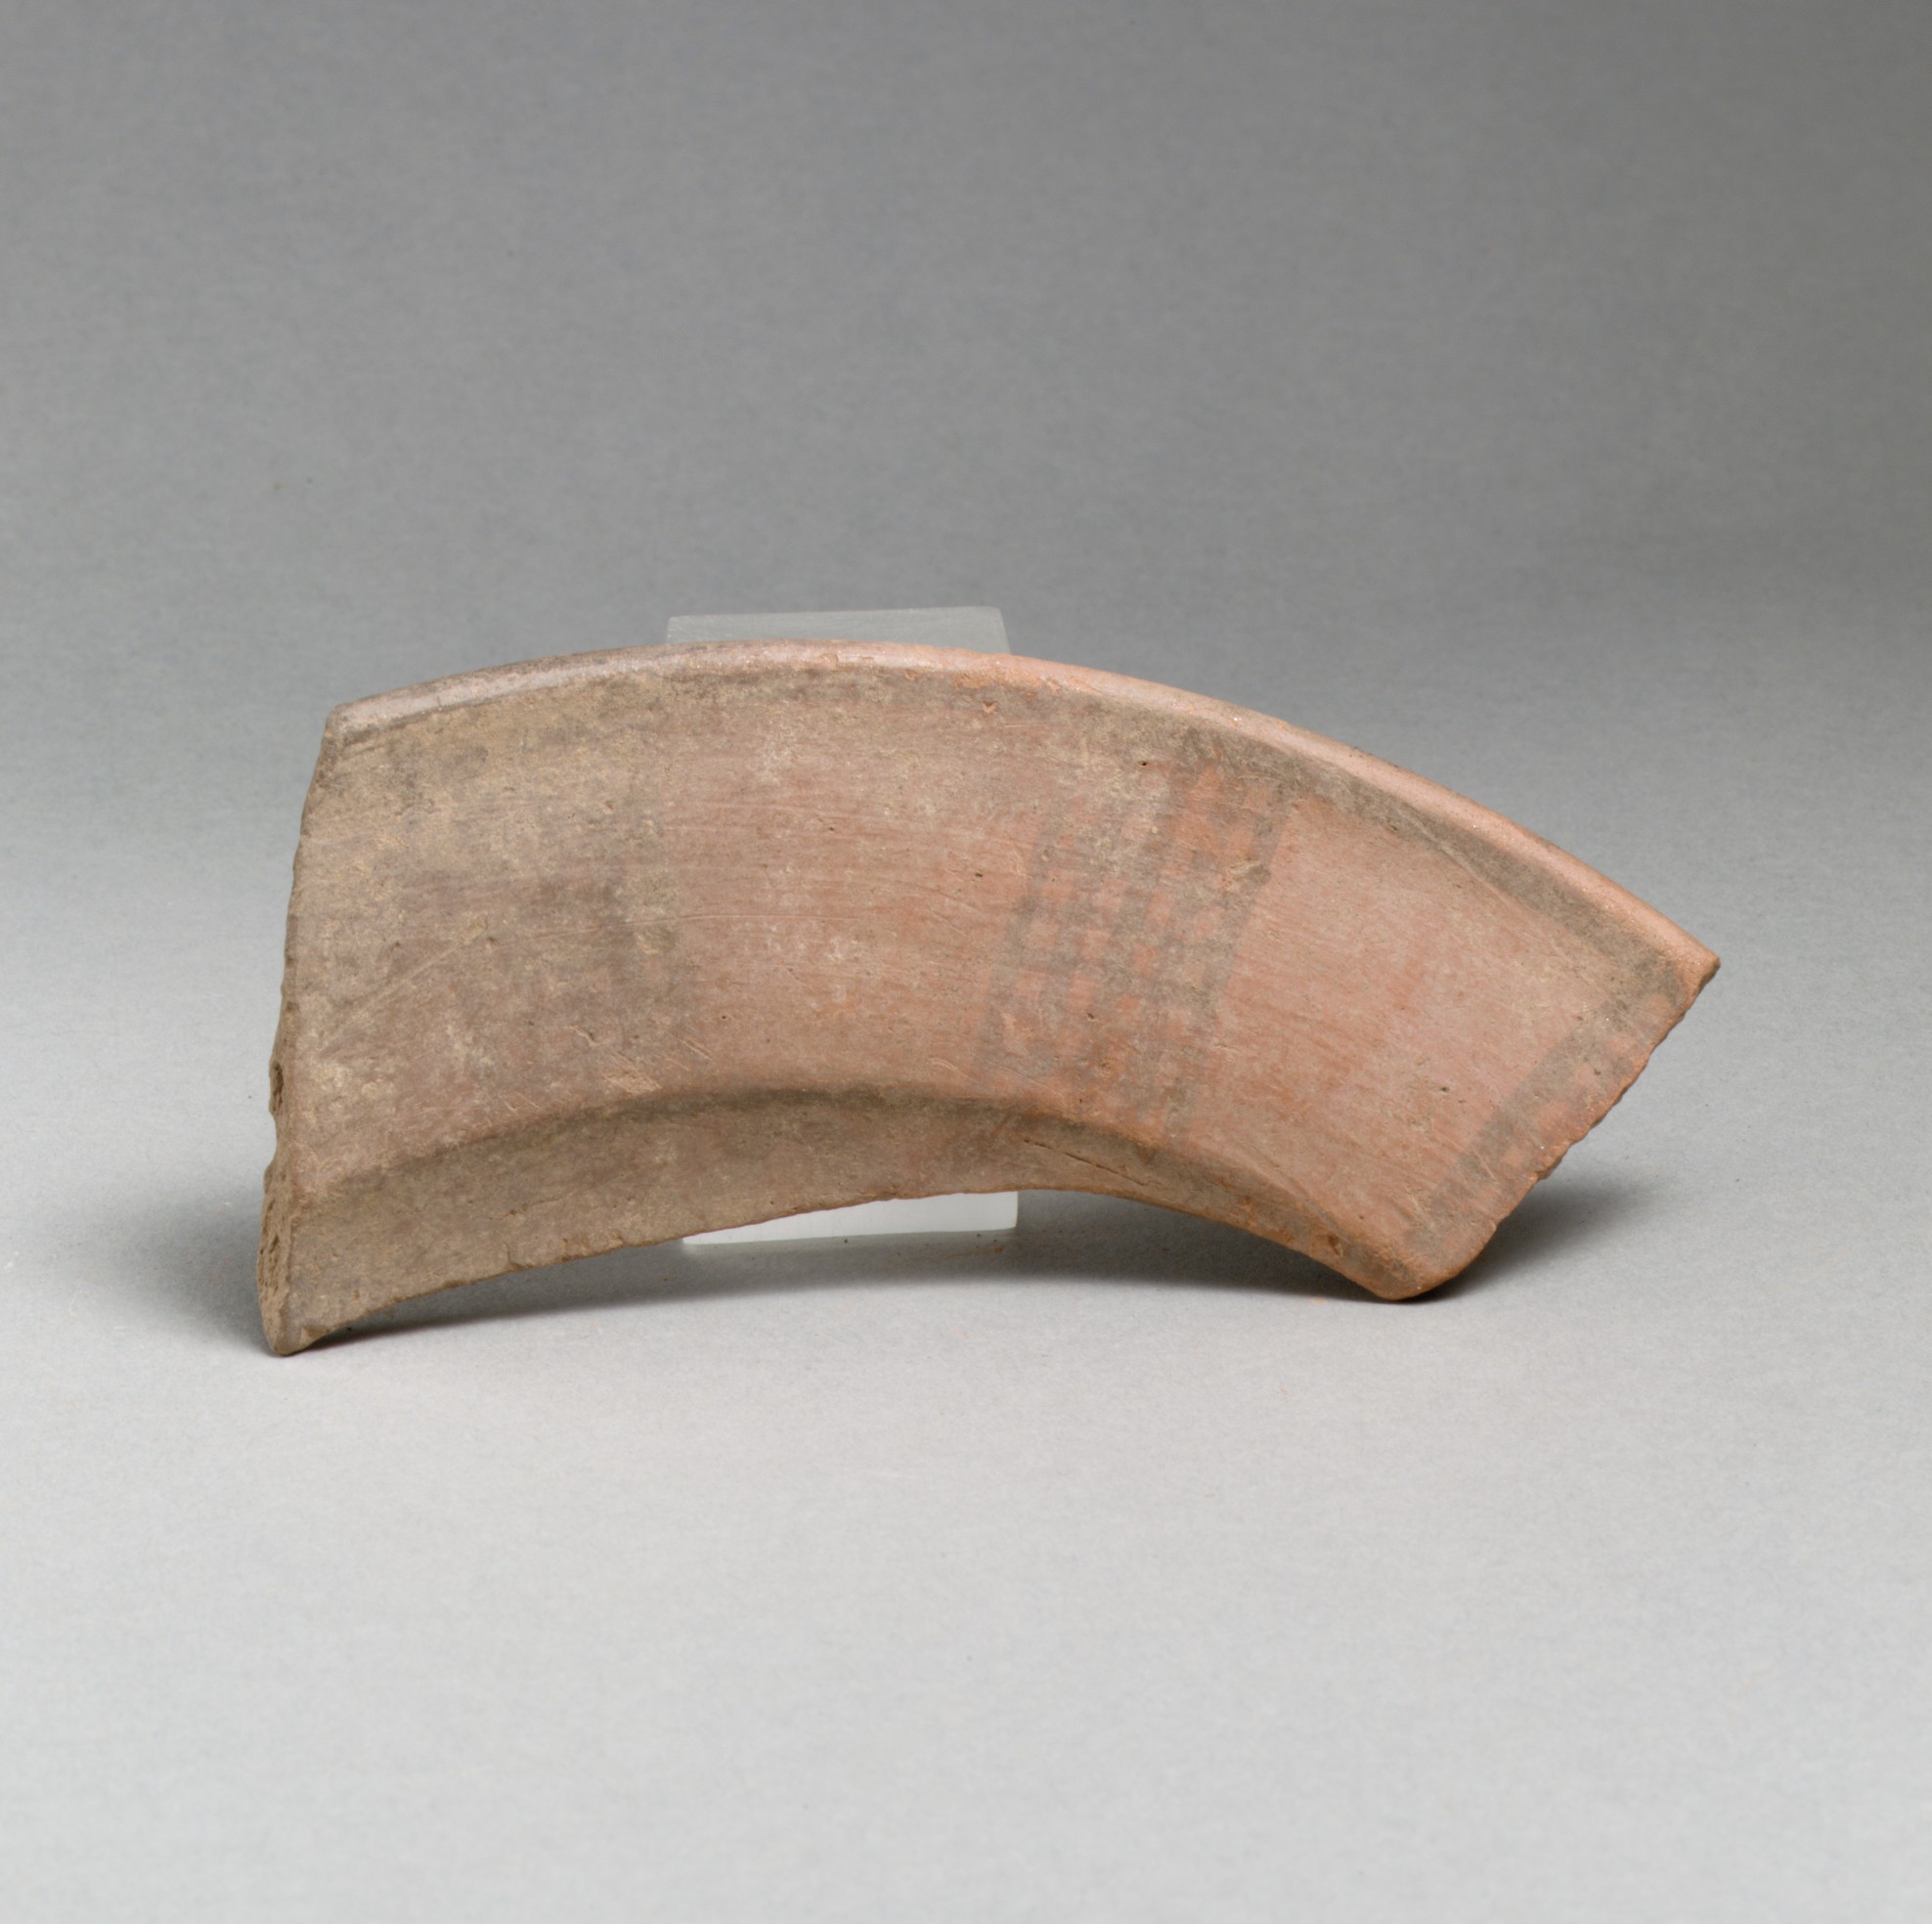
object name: vase fragment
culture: greek or lydian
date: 1050-700 BCE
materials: terracotta